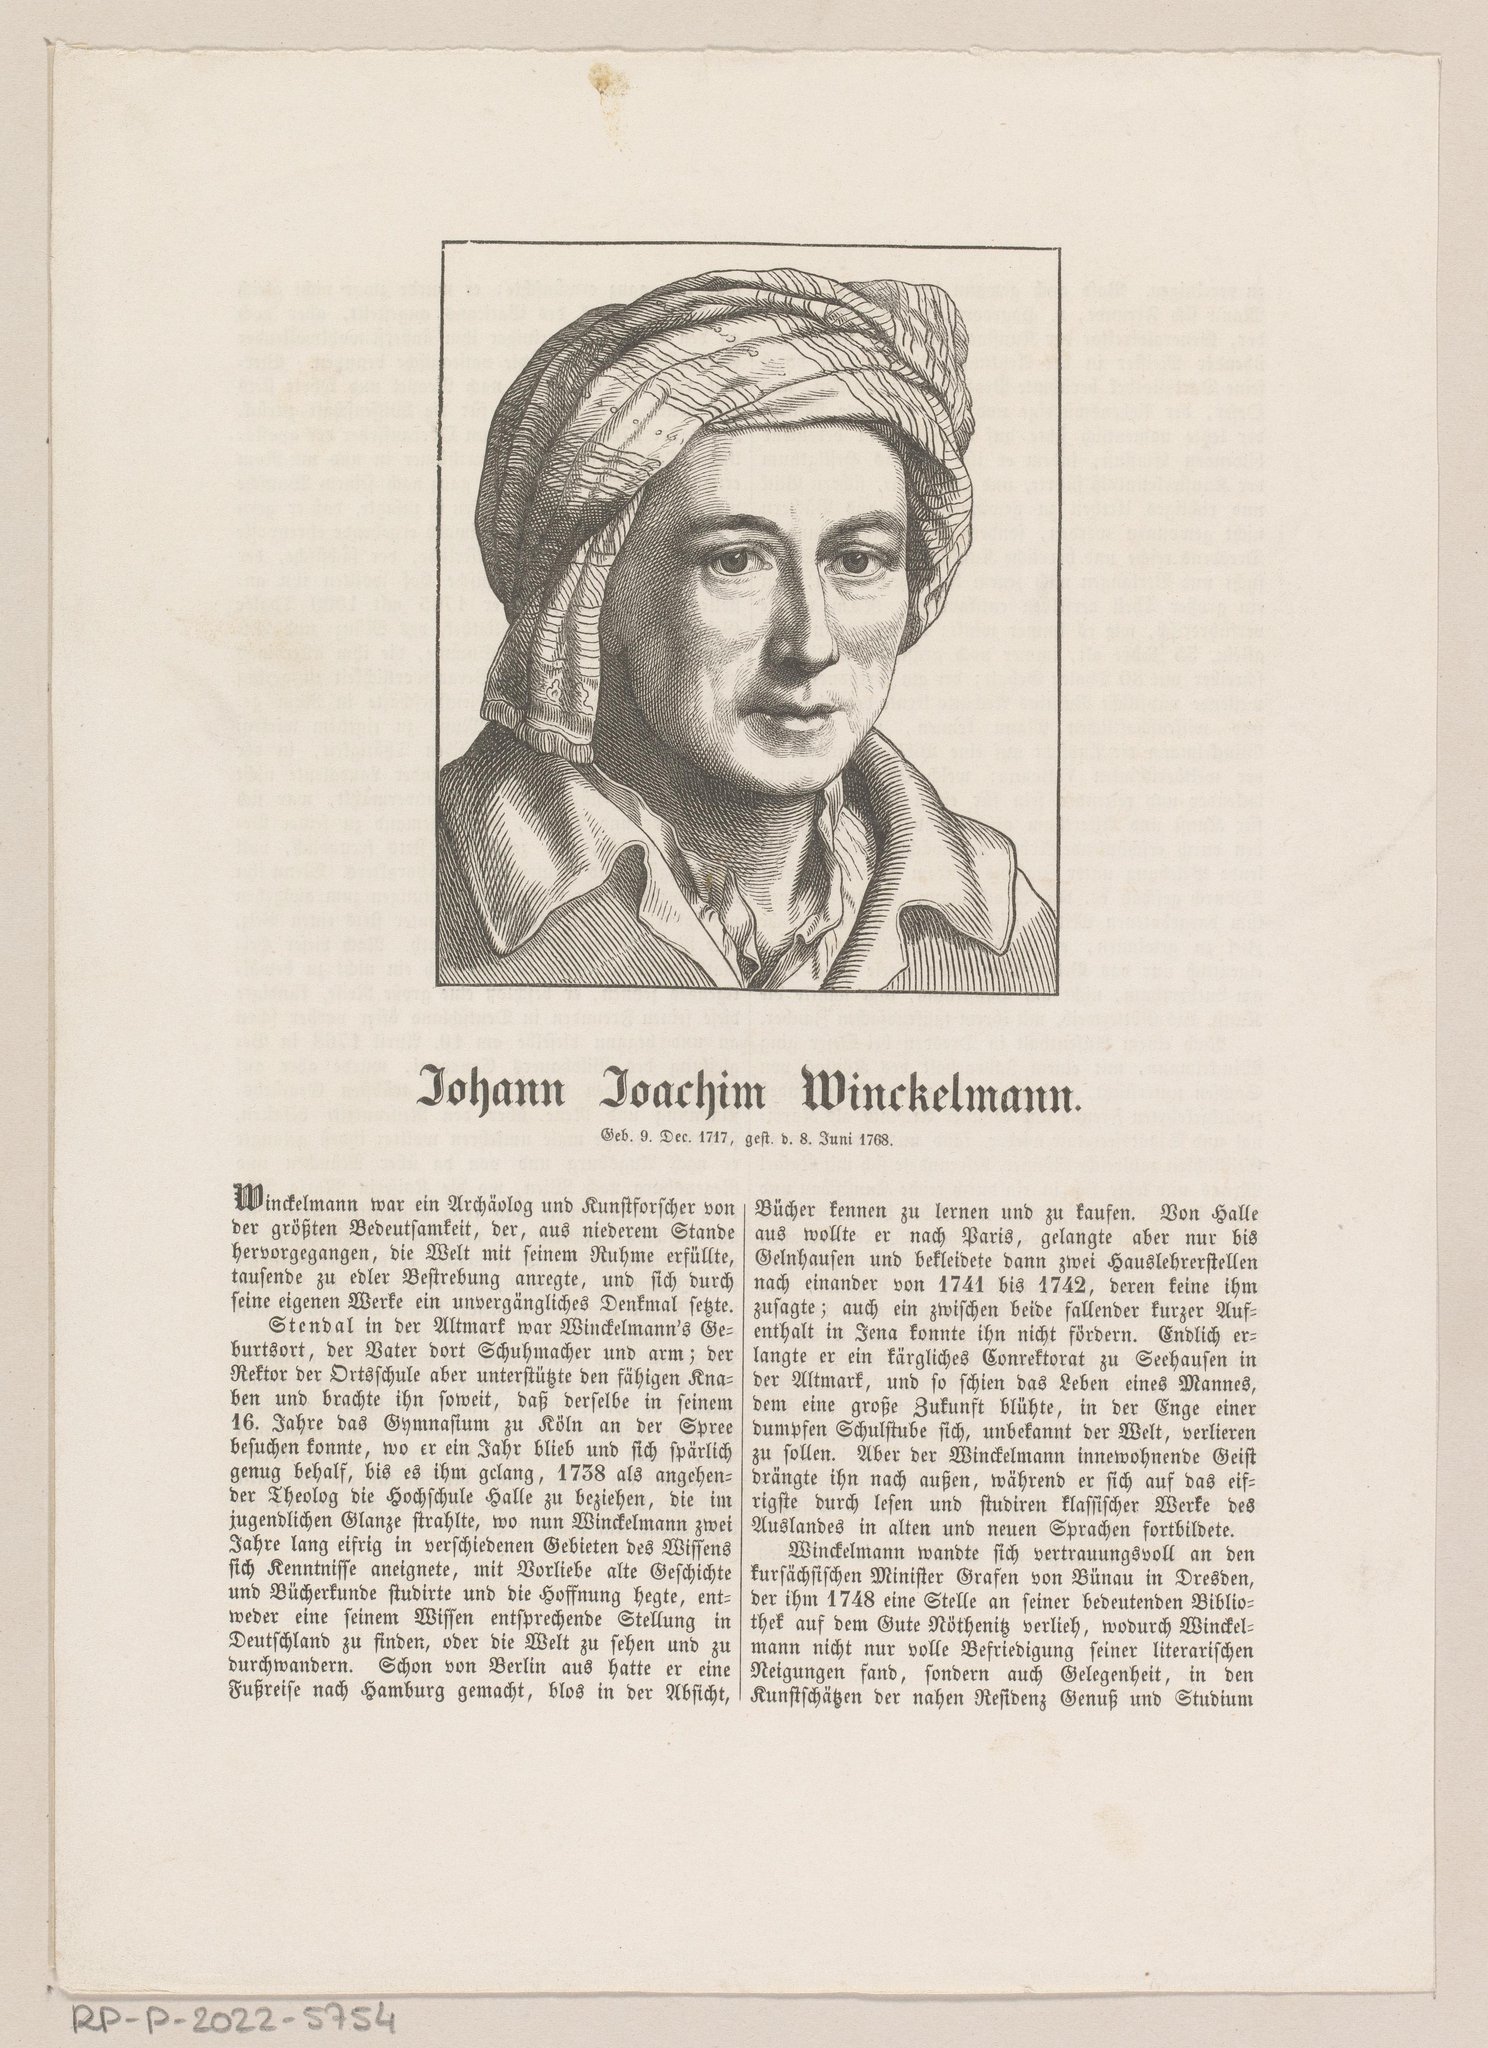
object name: book illustration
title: Portret van Johann Joachim Winckelmann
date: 1854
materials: paper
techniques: letterpress printing, engraving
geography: leipzig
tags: history and archaeology (+ portrait of scholar, scientist), historical persons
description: Bladzijde uit: Bechstein, Ludwig. Zweihundert deutsche Männer in Bildnissen und Lebensbeschreibungen. Leipzig: Georg Wigand, 1854. Prent met andere tekst gebruikt in: Gaedertz, Karl Theodor. Dreihundert Bildnisse und Lebensabrisse berühmter deutscher Männer. Leipzig: Georg Wigand, 1890. Bij de uitgave uit 1890 staat op de titelpagina vermeld dat de prenten zijn gemaakt door Hugo Bürkner.